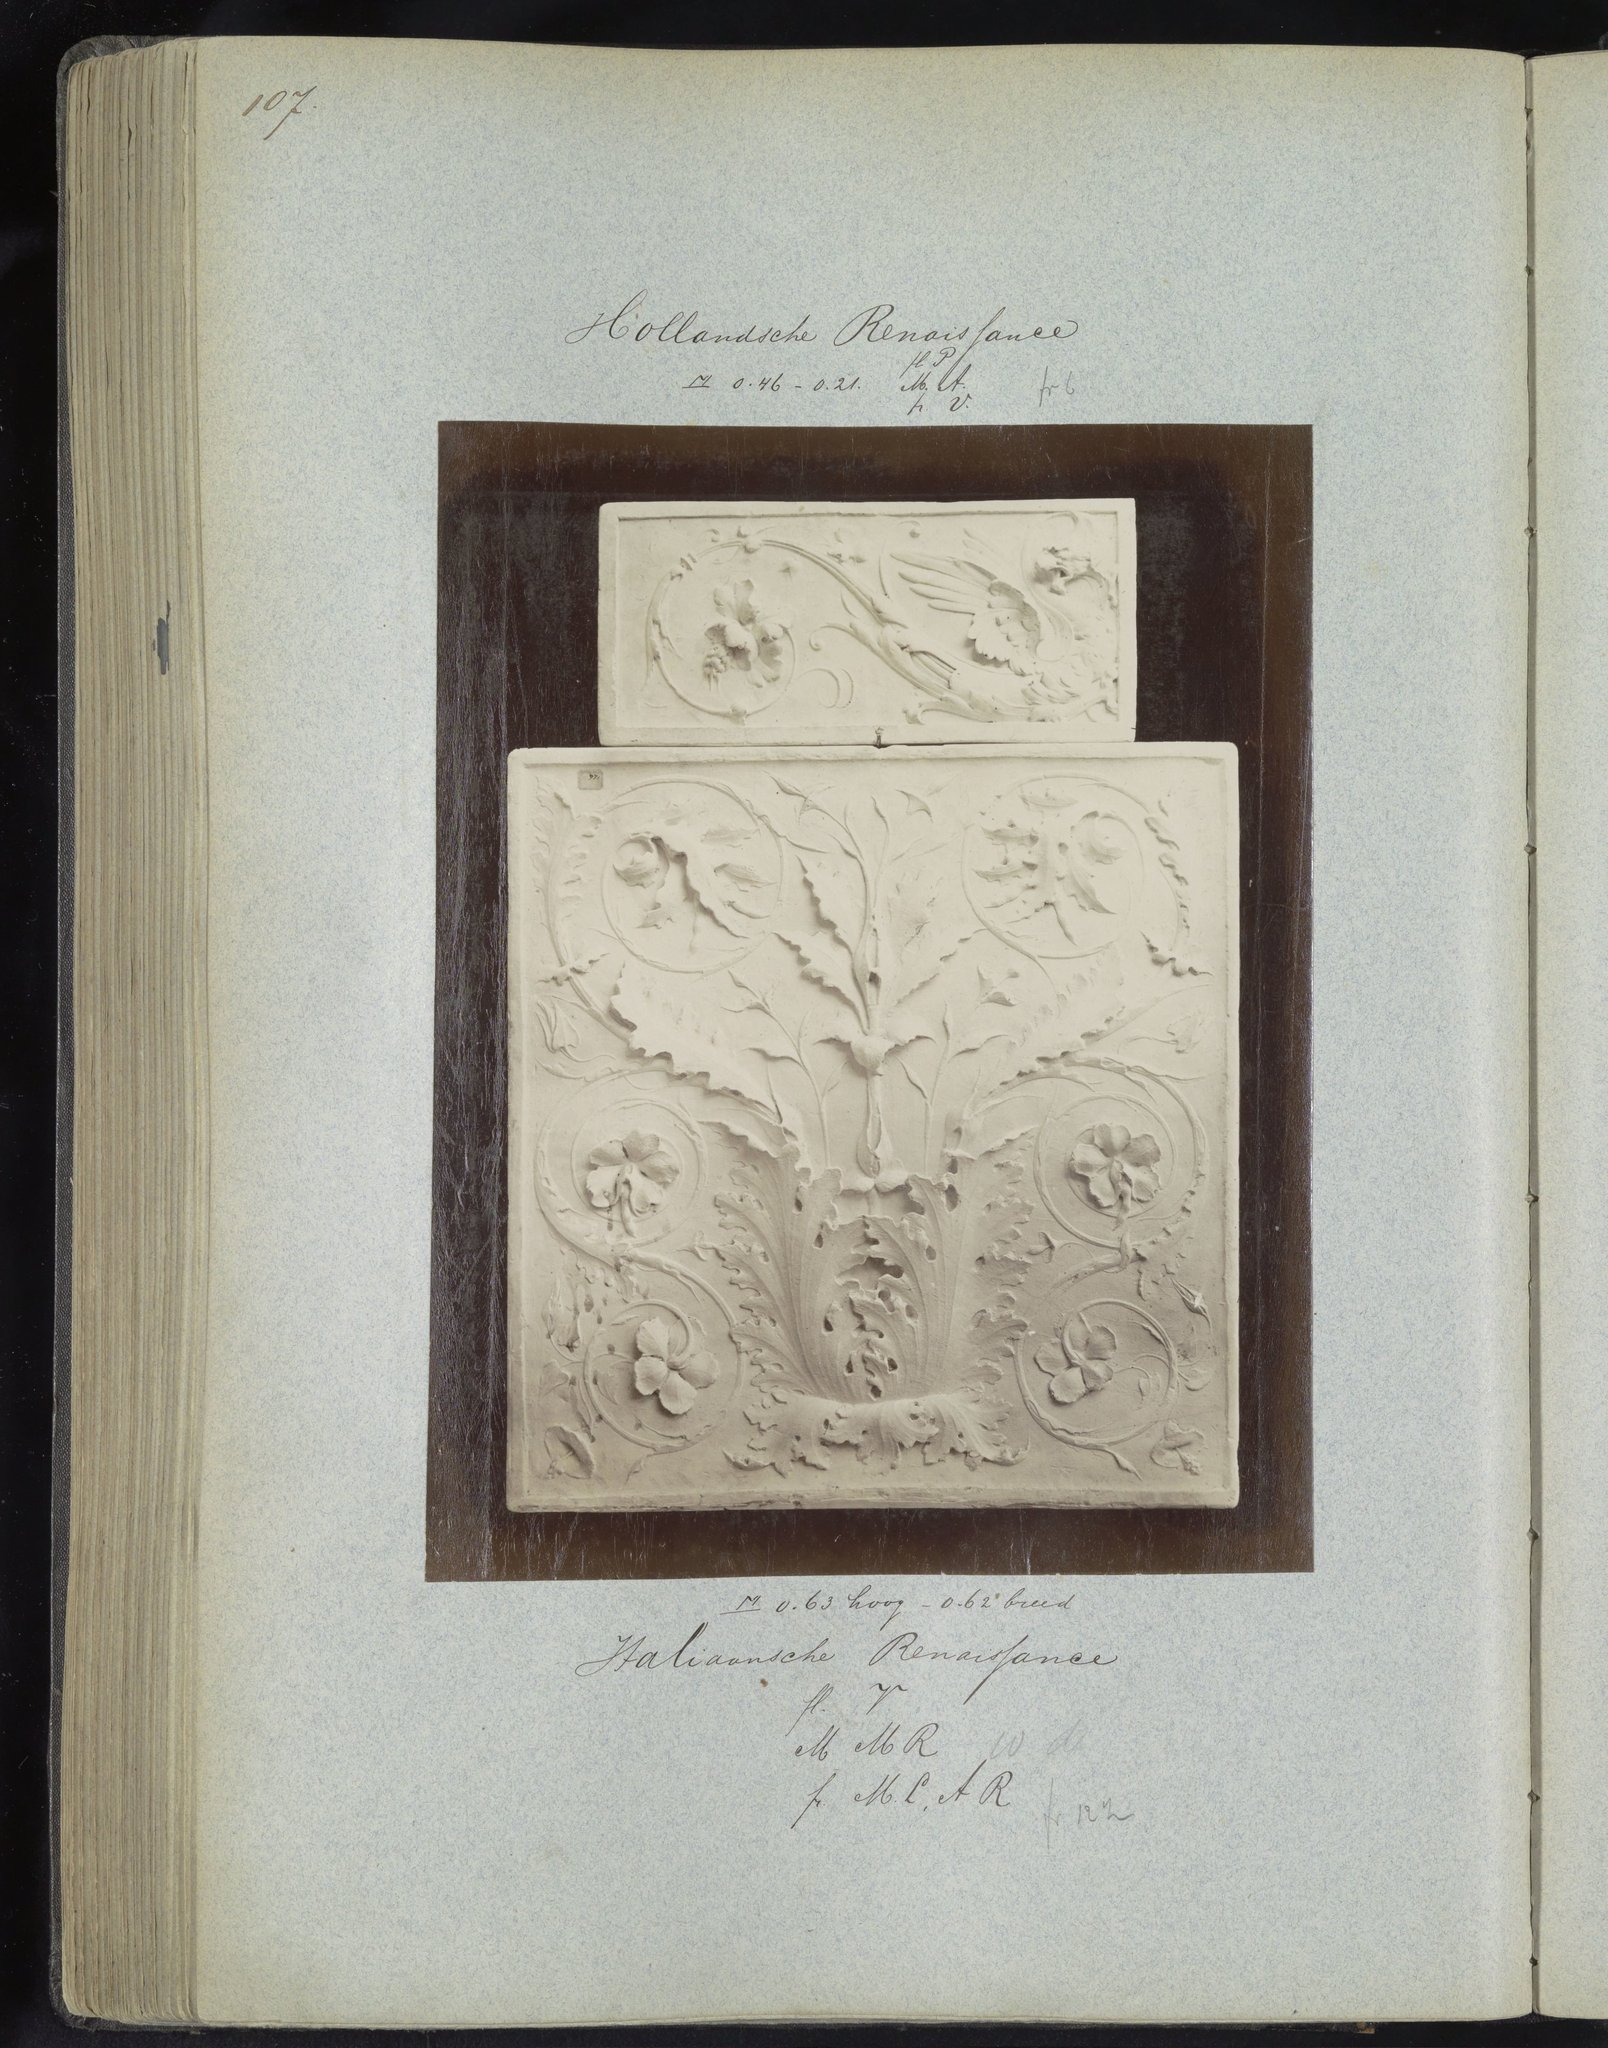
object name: photograph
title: Gipsen afgietsels van panelen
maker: Anonymous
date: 1875-1900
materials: paper, photographic support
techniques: albumen print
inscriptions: annotation: ‘Italiaansche Renaissance / M 0.46-0.21’, annotation: ‘M 0.63 hoog - 0.62 breed / Hollandsche Renaissance’